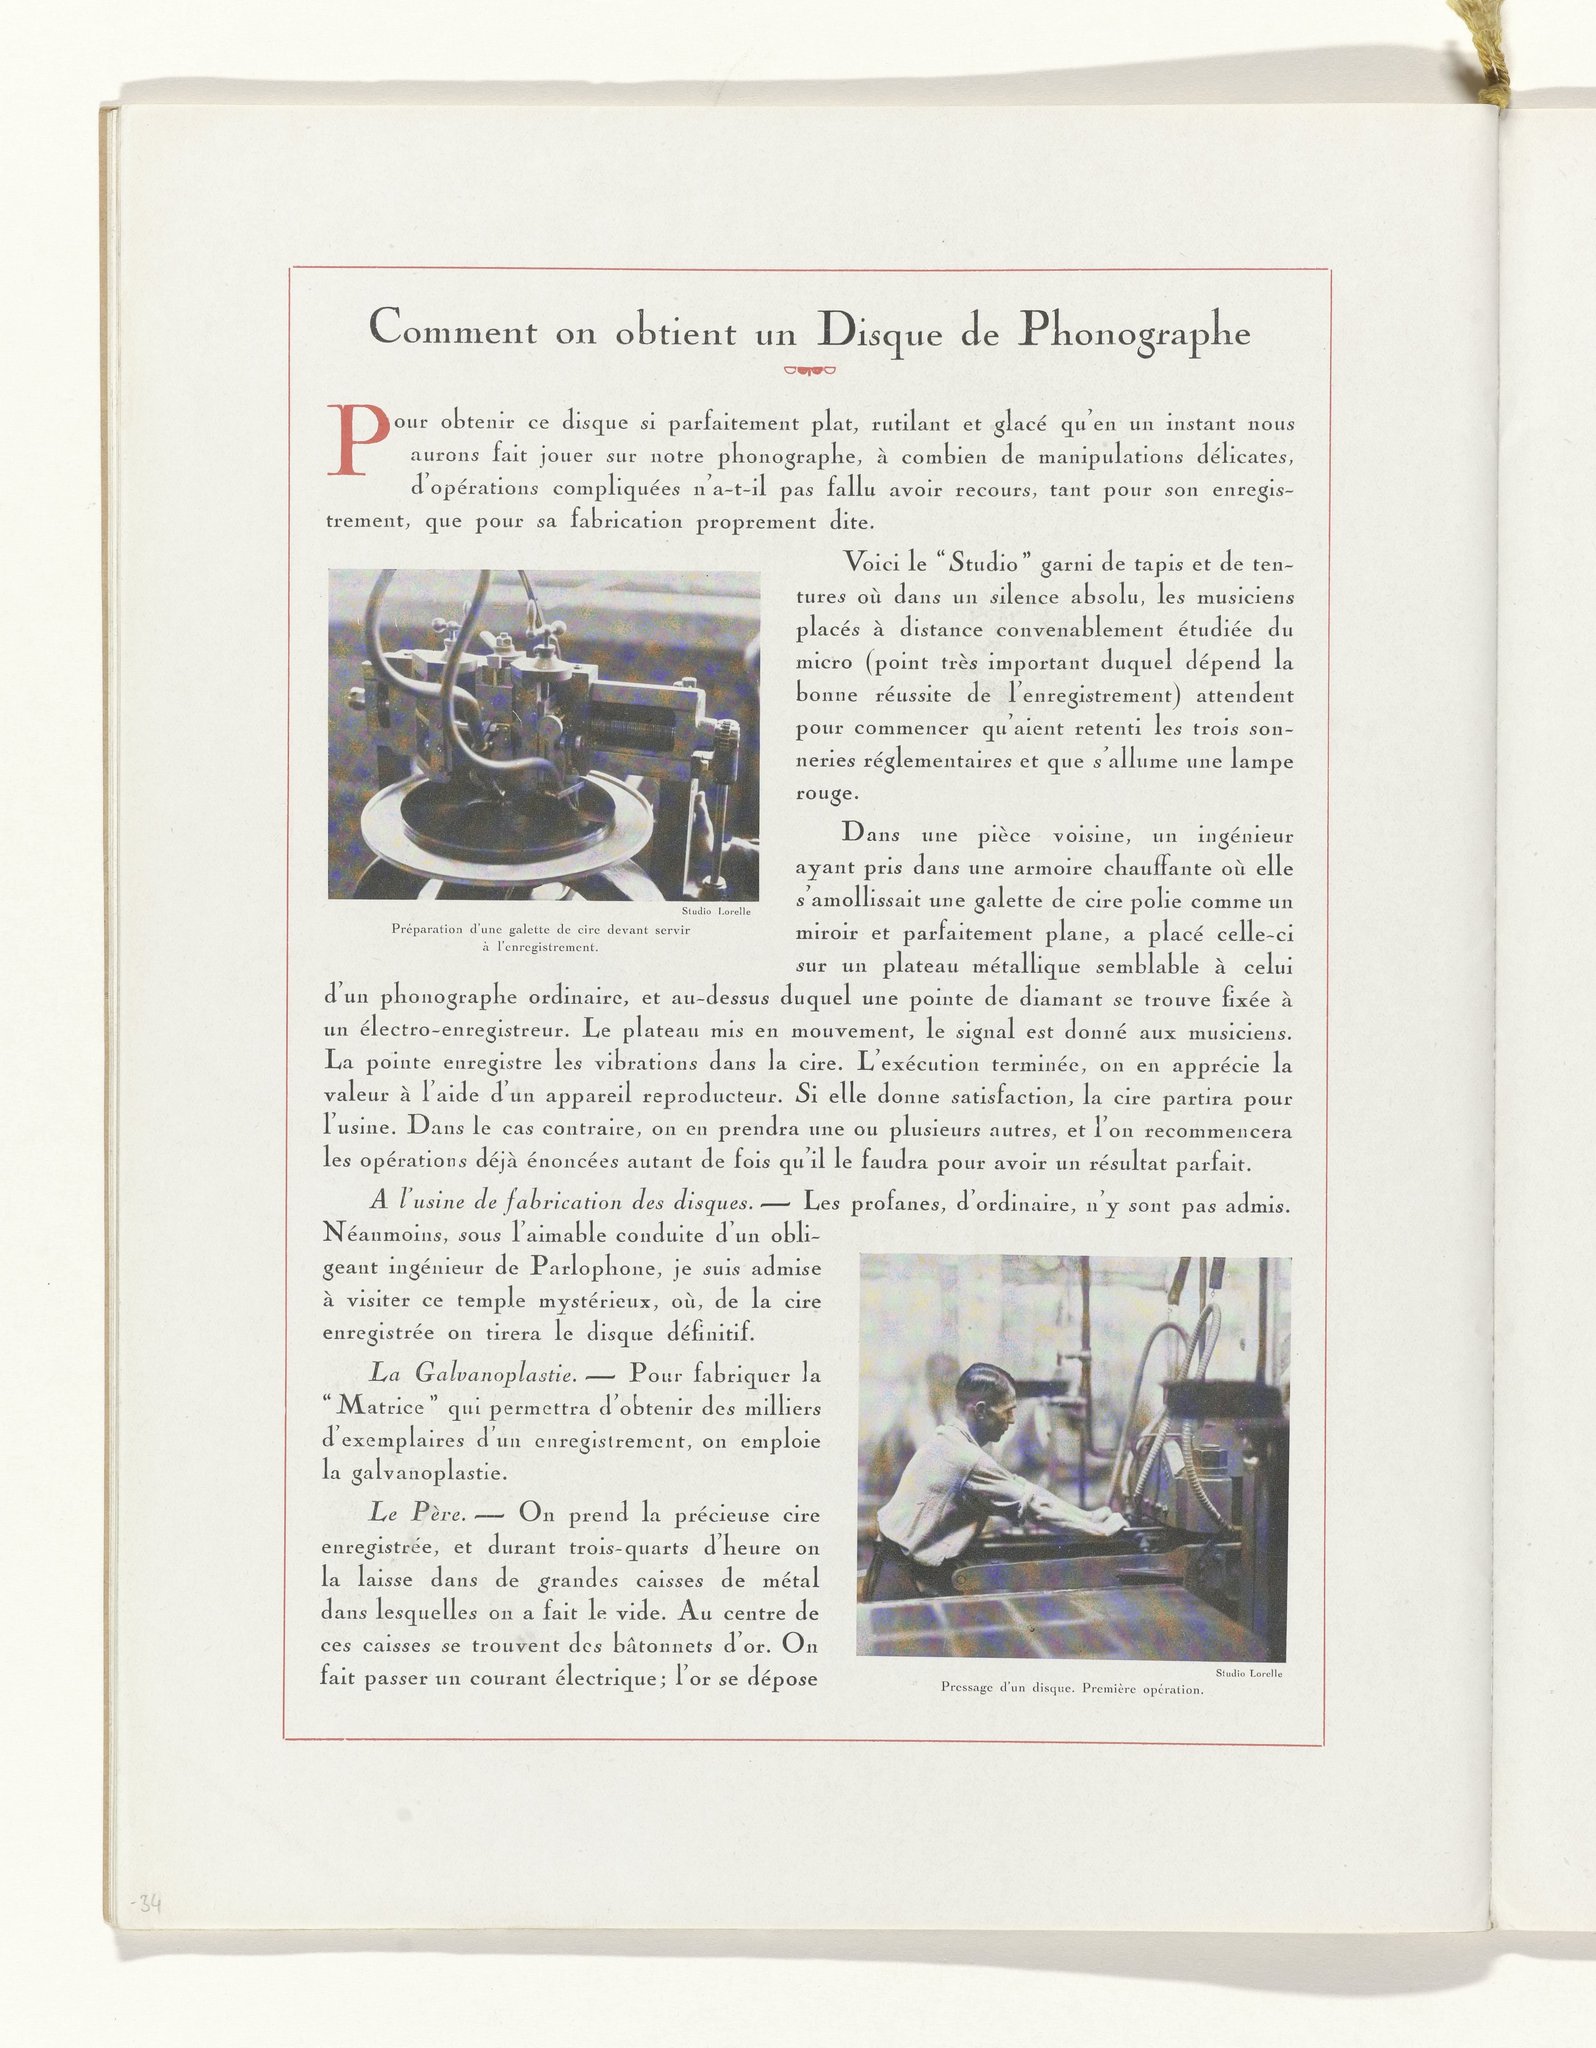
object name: magazine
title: Art - Goût - Beauté, Feuillets de l' élégance féminine, Novembre 1931, No. 135, 12e Année, p. 34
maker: charles goy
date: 1931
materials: paper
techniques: printing, photography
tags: fashion plates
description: Tekst 'Comment on obtient un Disque de Phonographe' met twee foto's van verschillende stadia in het productieproces van langspeelplaten. Pagina uit het modetijdschrift Art-Goût-Beauté (1920-1933).